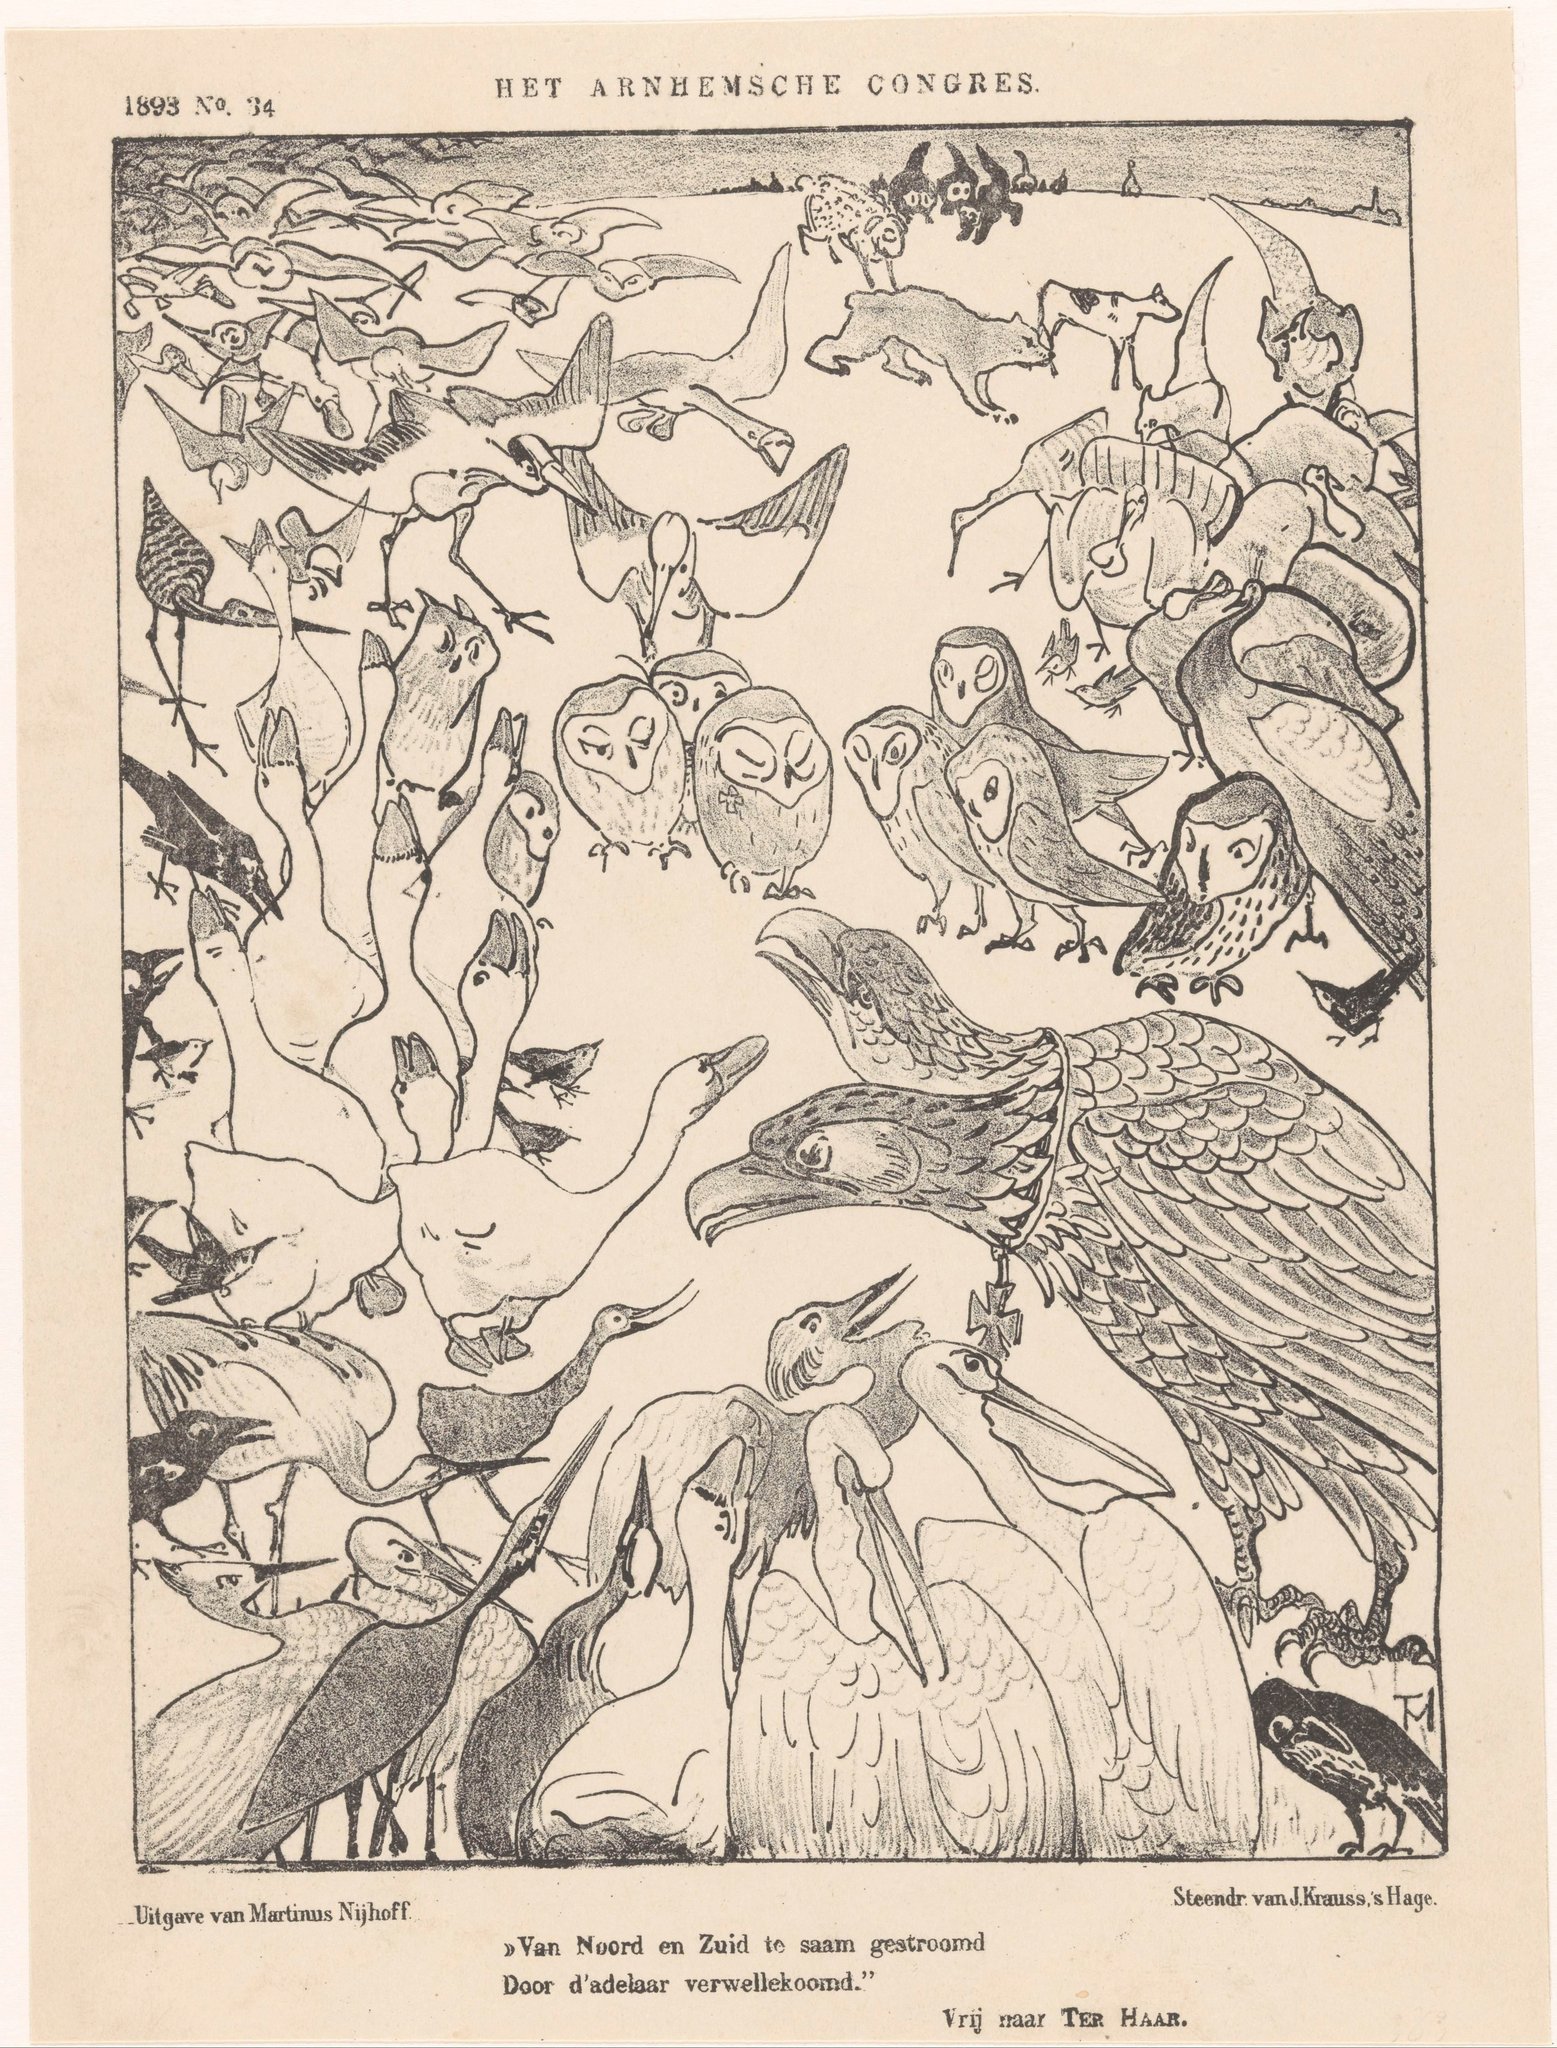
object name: print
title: Tweekoppige adelaar omringd door vogels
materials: paper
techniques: letterpress printing, lithograph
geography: the hague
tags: double-headed eagle, groups of birds, geese (domestic waterbirds), owls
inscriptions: collector's mark: Lugt 2228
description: Prent gebruikt voor: De Nederlandse Spectator 34 (1893), ter gelegenheid van het tweeëntwintigste taal- en letterkundig congres te Arnhem.